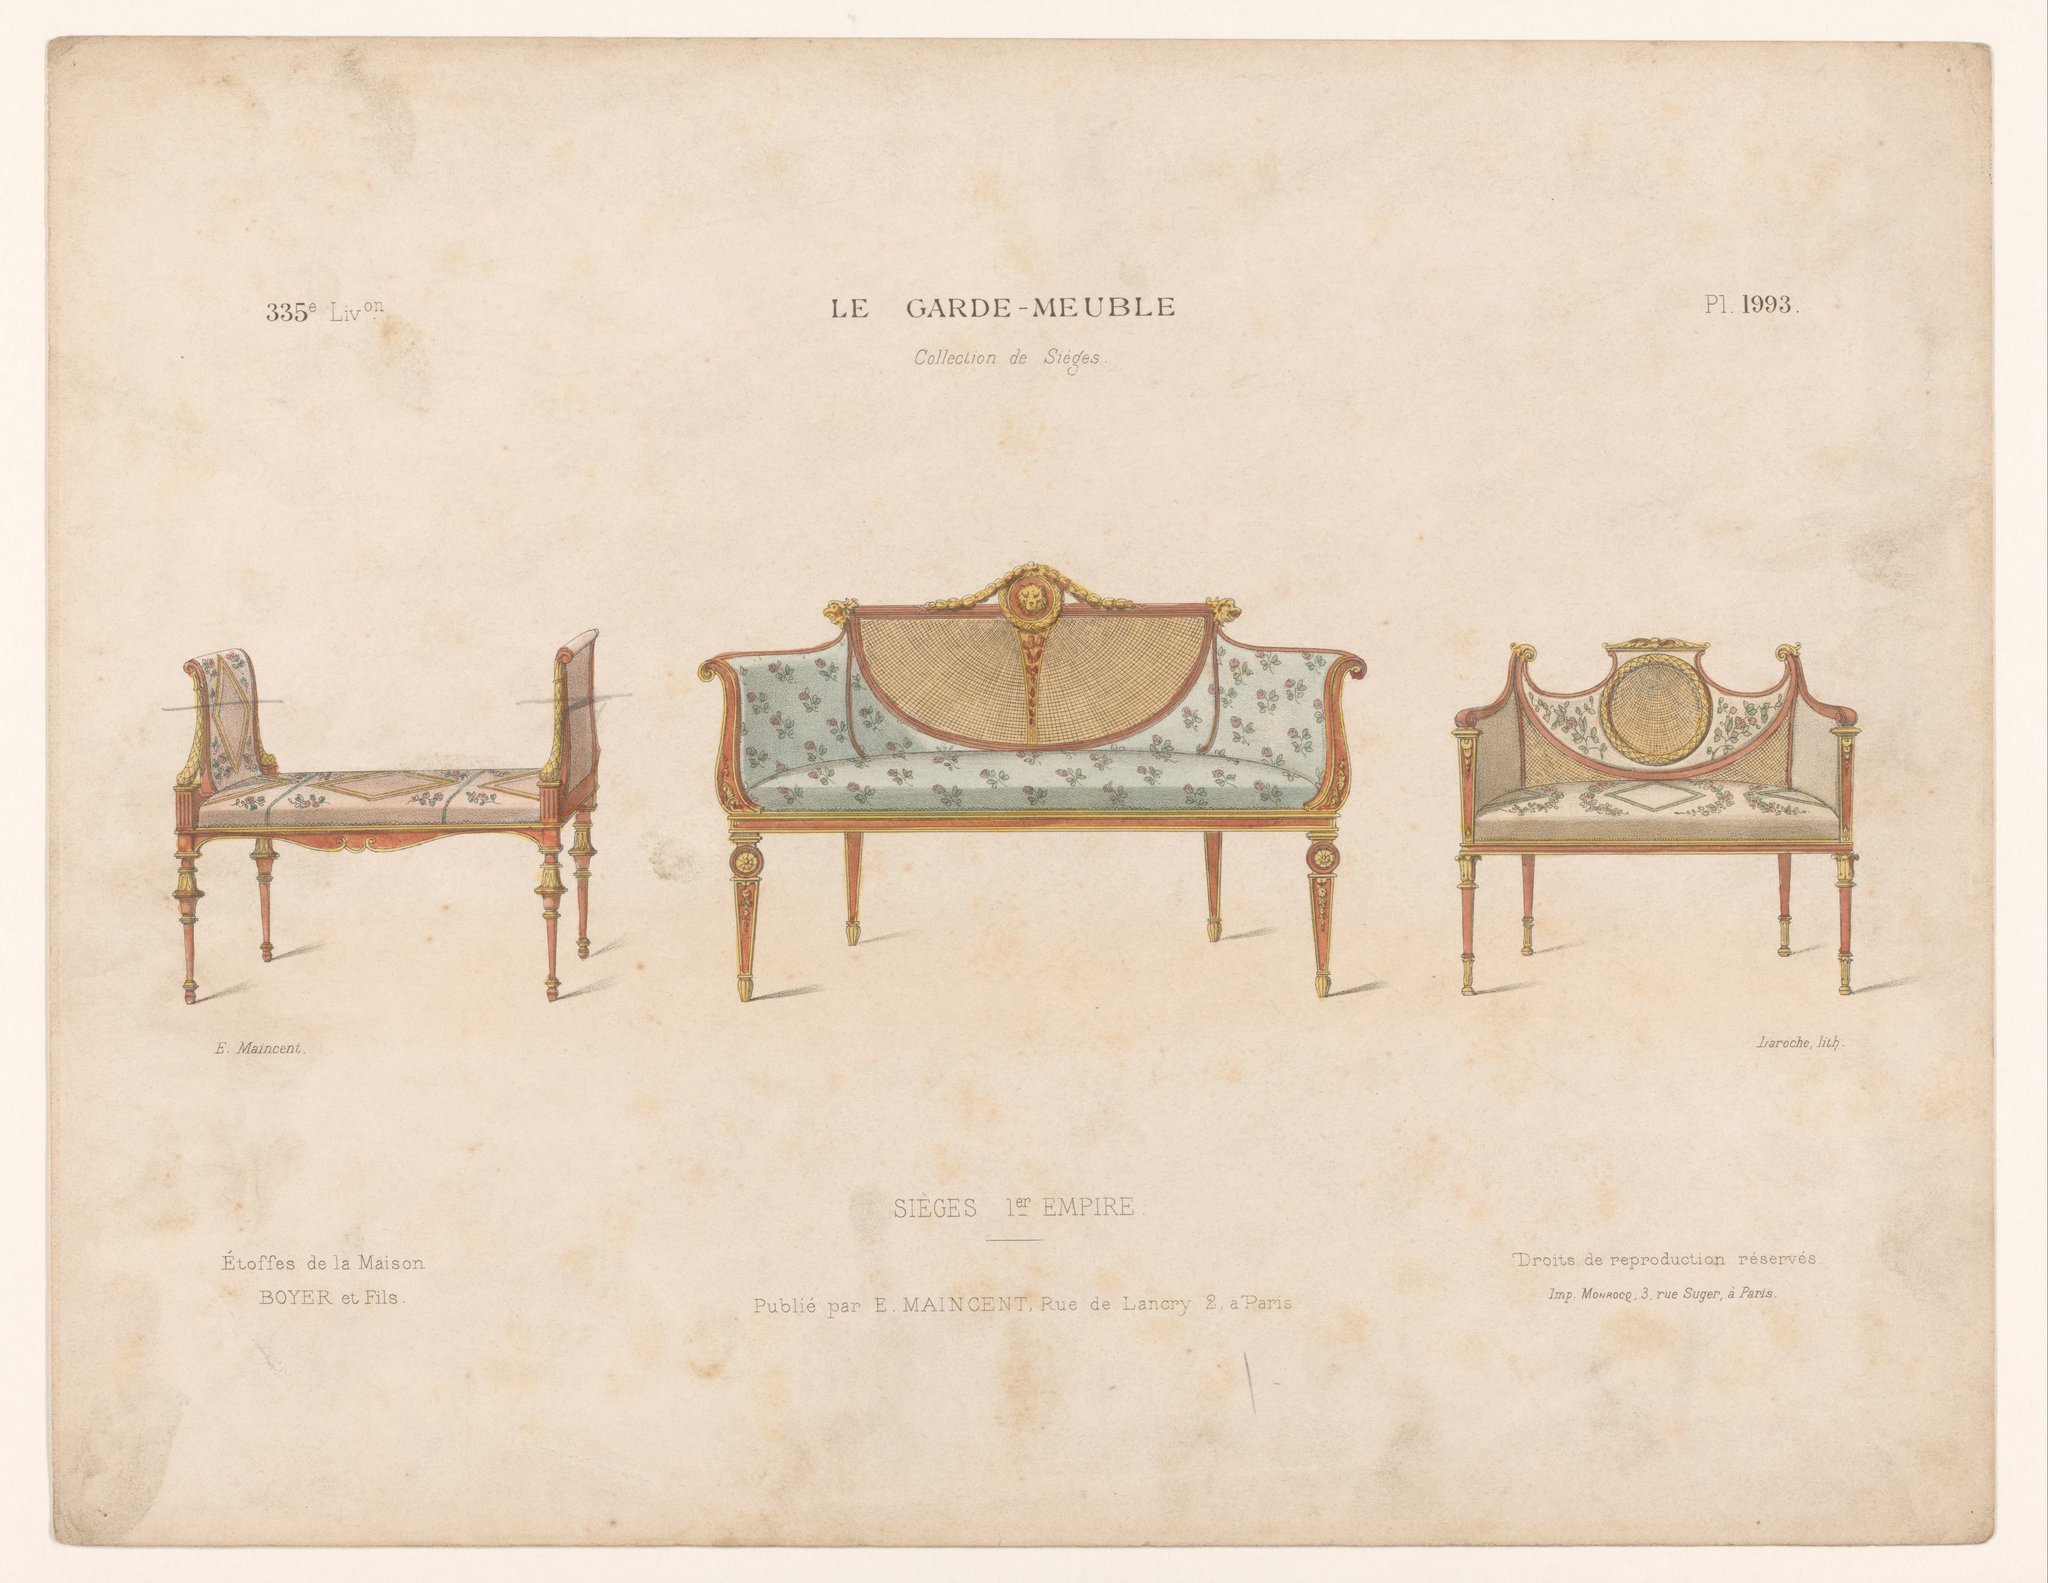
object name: print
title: Le garde-meuble / Collection de Sièges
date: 1885-1895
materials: paper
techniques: hand coloring, lithograph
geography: paris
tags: seating furniture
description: Ieder Livraison in de serie Le Garde-Meuble bevat negen platen: drie 'sièges' (zitmeubels), drie 'meubles' (diverse meubels zoals tafels en kasten) en drie 'tentures' (gordijnen en draperieën).